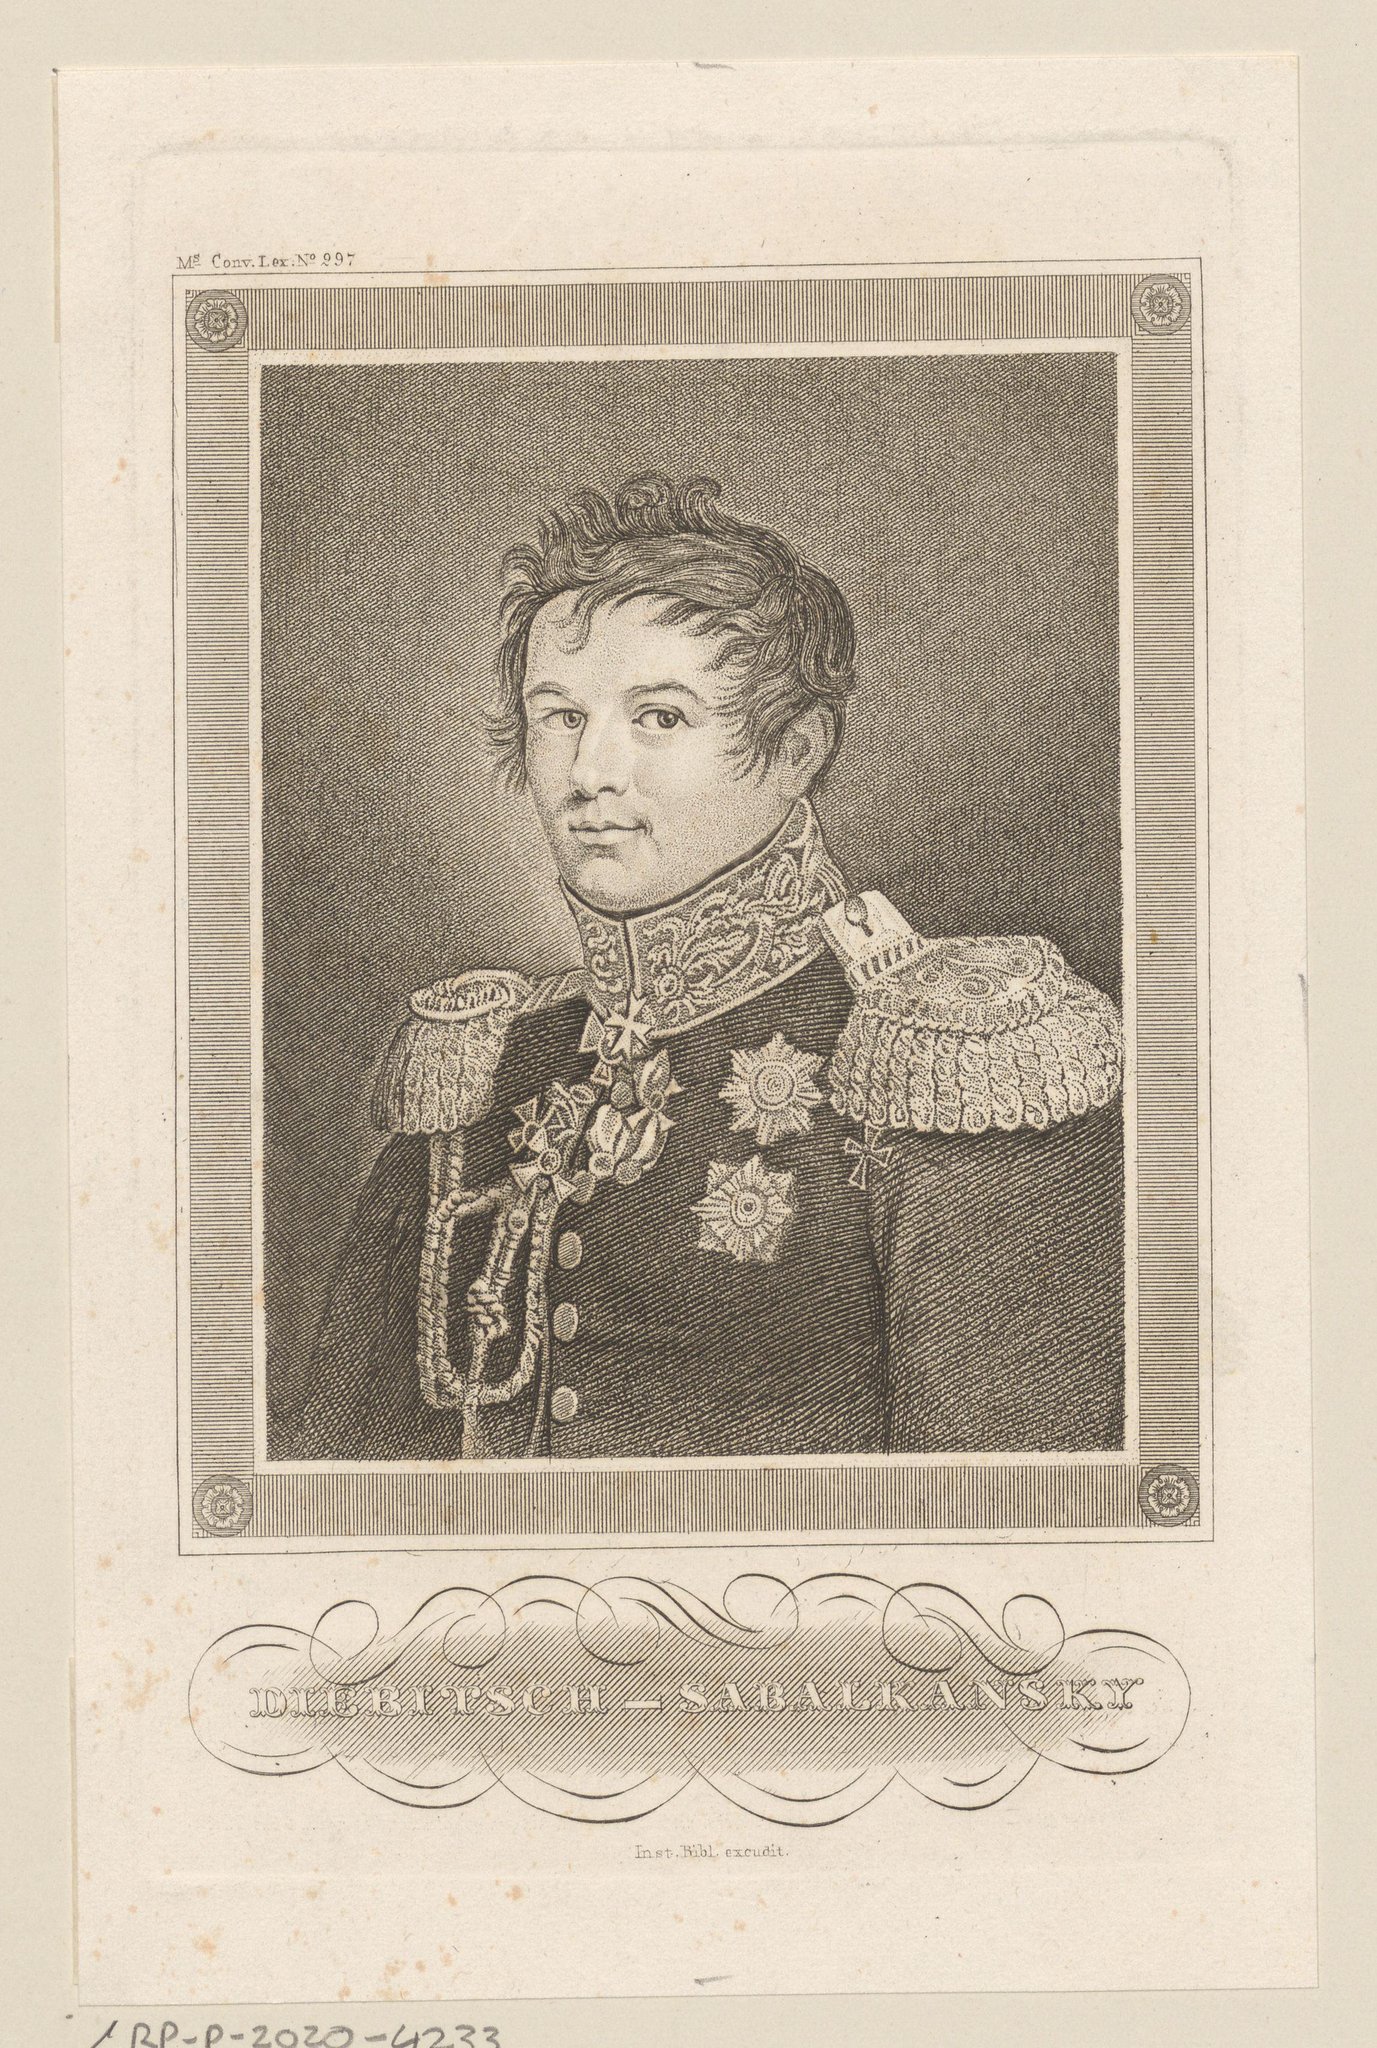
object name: print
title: Portret van Hans Karl von Diebitsch-Sabalkanski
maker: Anonymous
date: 1840-1855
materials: paper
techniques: engraving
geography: hildburghausen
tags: knighthood order (with name) - insignia of a knighthood order, e.g.: badge, chain (with name of order), commander-in-chief, general, marshal, historical persons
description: Prent waarschijnlijk uit: Meyer, Joseph. Das Grosse Conversations-Lexikon für die gebildeten Stände. Hildburghausen: Bibliographisches Institut, 1840-1855.